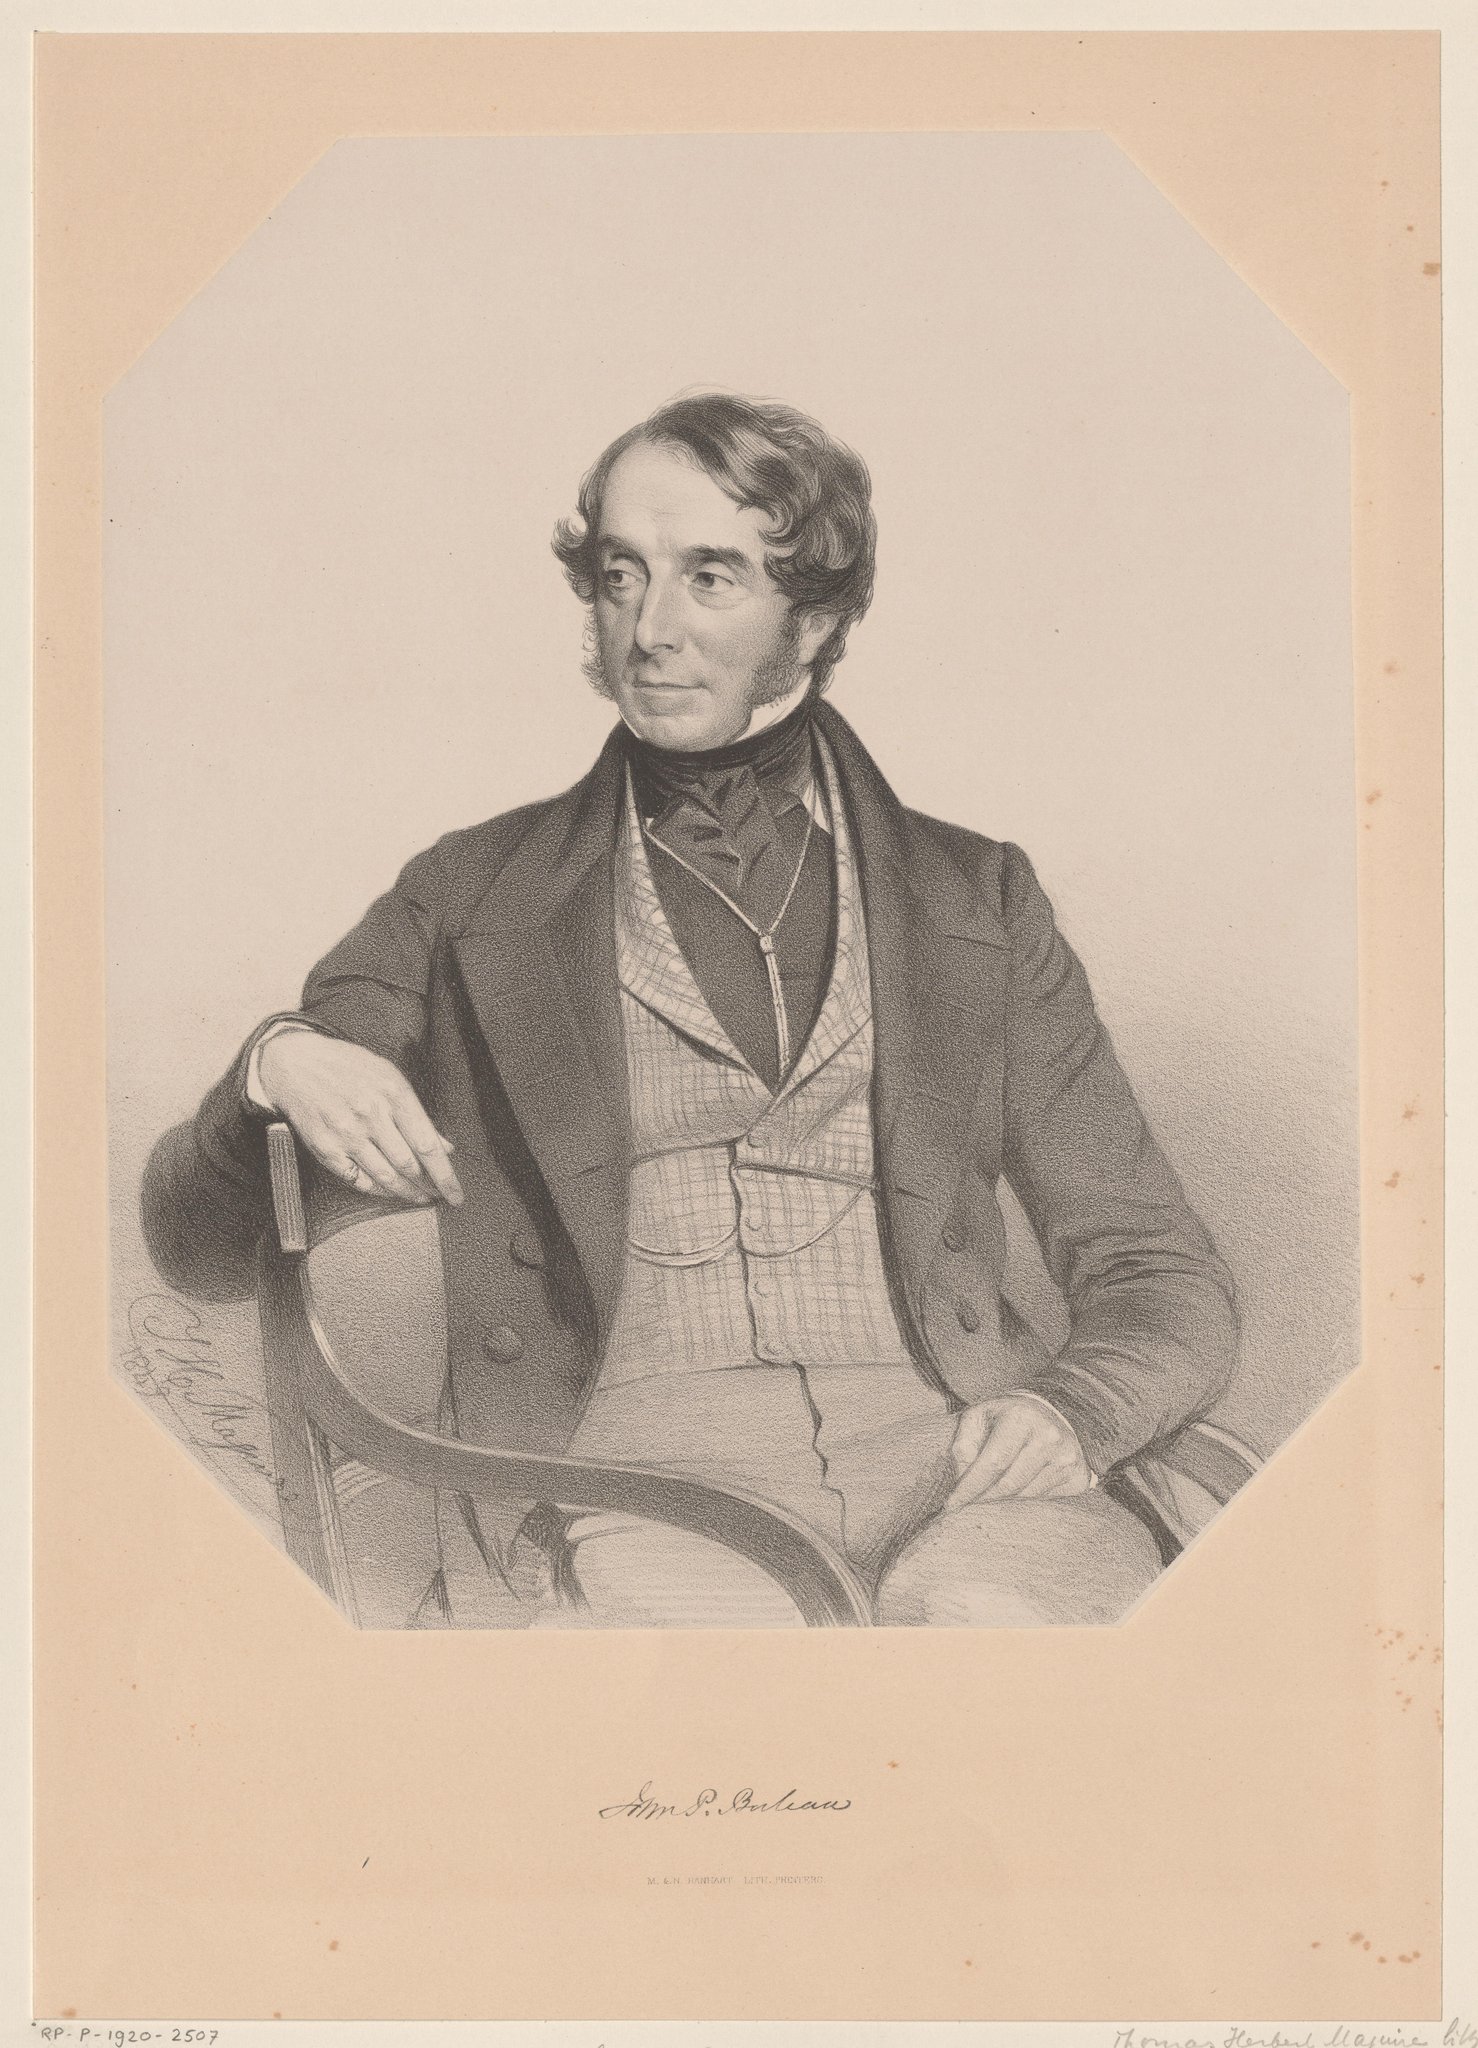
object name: print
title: Portret van John Peter Boileau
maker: thomas herbert maguire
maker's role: print maker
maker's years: 1821-1895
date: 1849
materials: paper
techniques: lithograph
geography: london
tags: historical persons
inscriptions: collector's mark: Lugt 2228